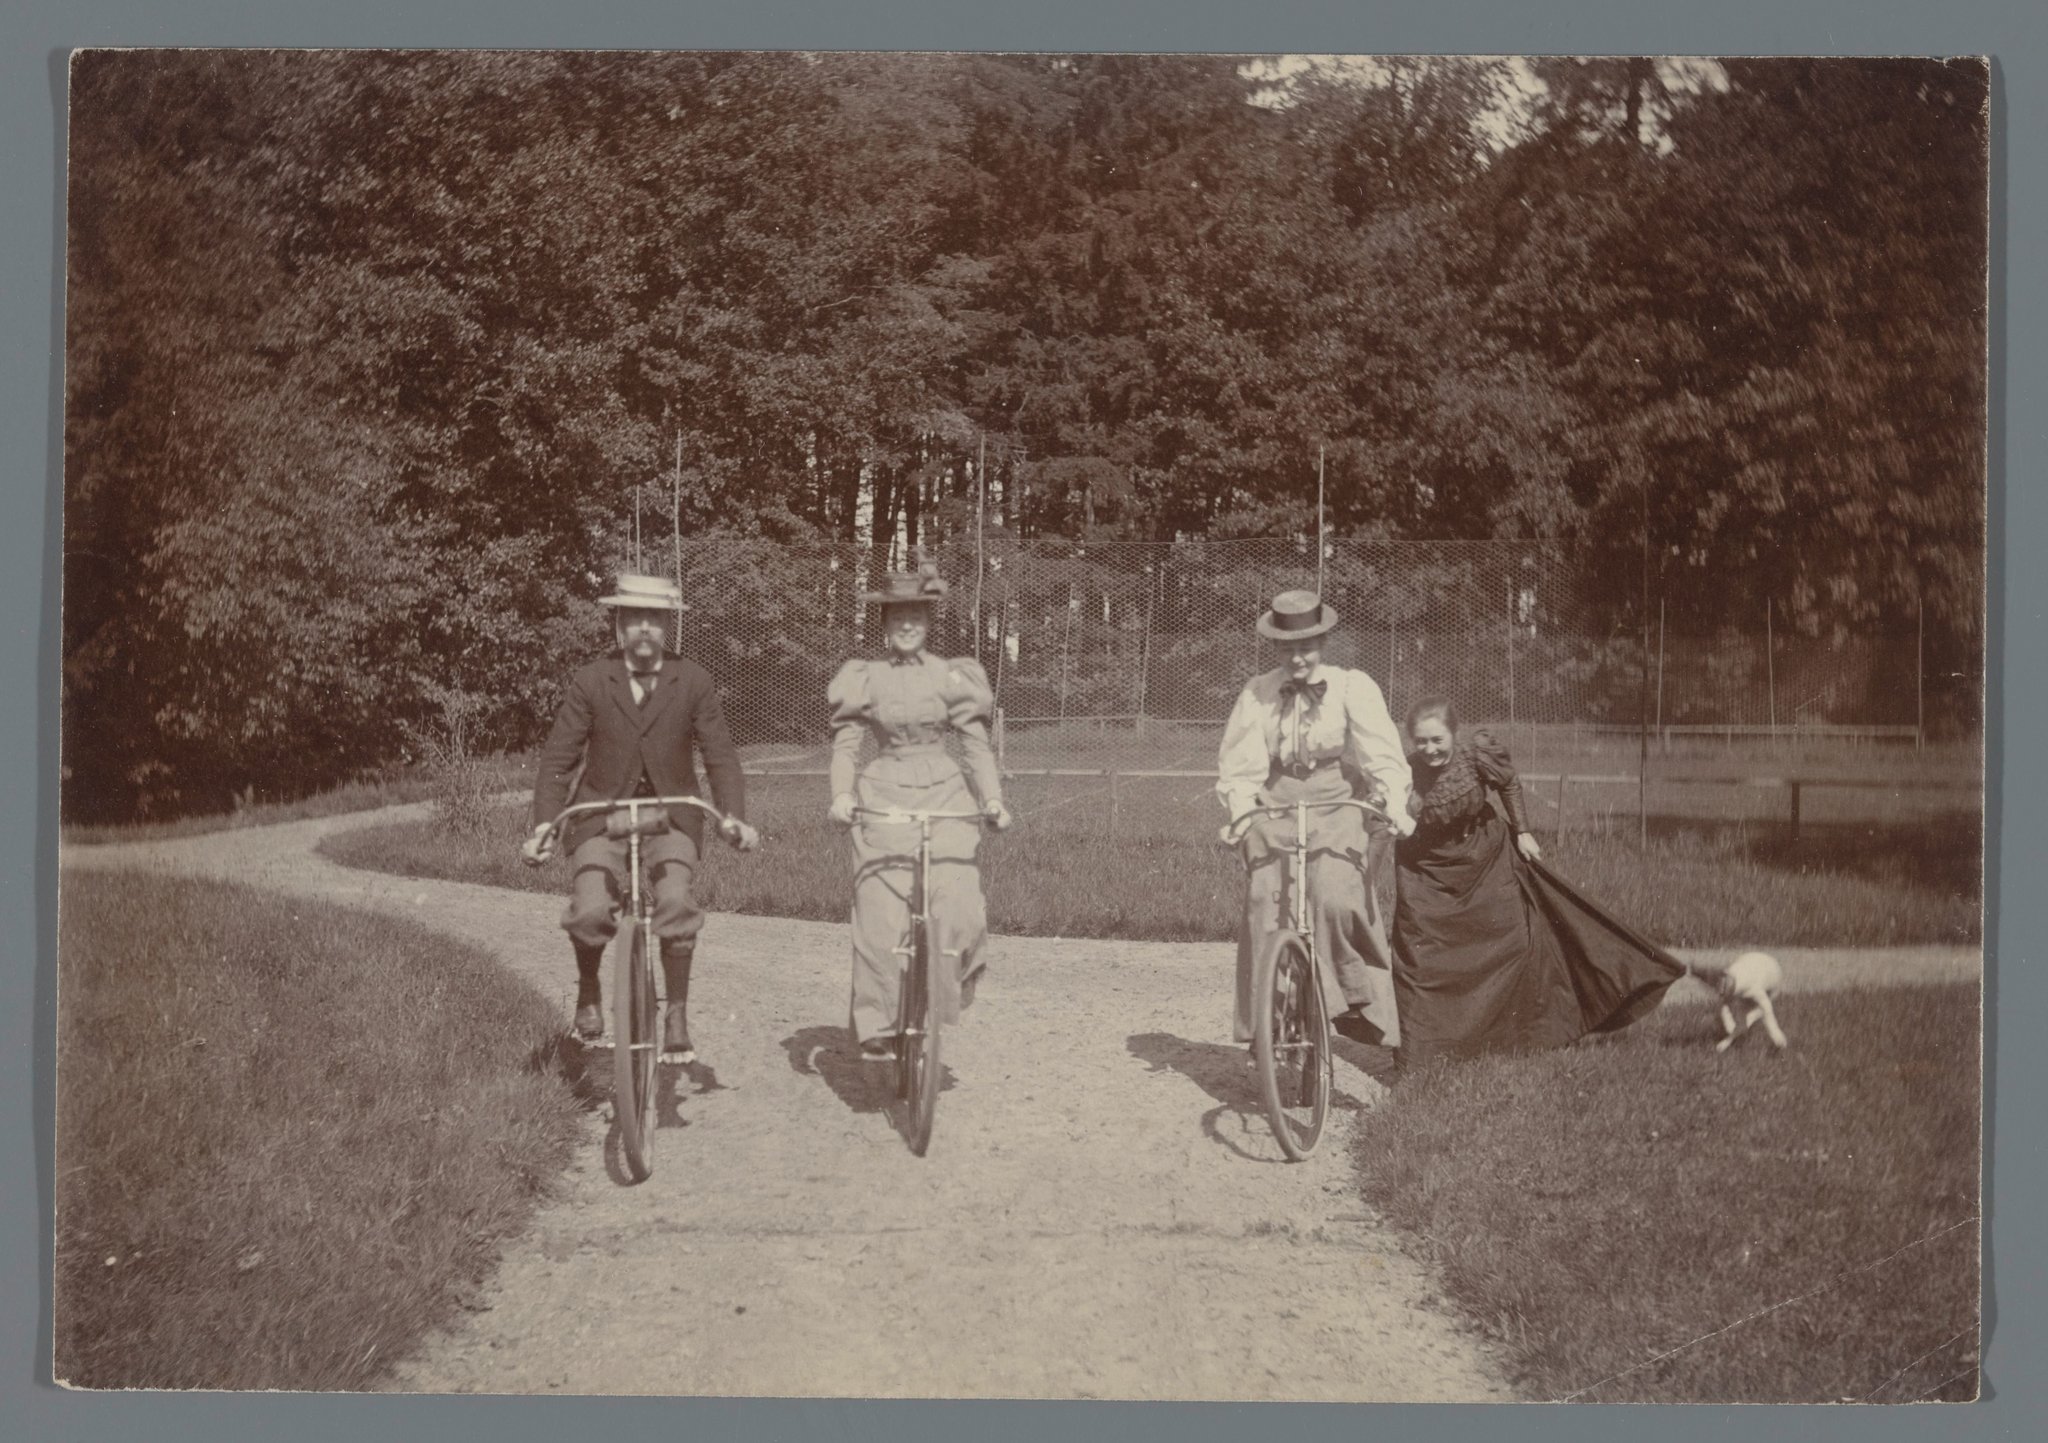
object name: photograph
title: Groepsportret op de fiets van Willem, Maria Engelina, Jennigje Hendrika Jacoba en Johanna Geertruida Jonker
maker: cornelia hendrika jonker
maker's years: 1874-1924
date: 1890-1910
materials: photographic support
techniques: collodion silver print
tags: historical persons, bicycle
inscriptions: annotation: ‘Wil, Marie, Jen, Jo Jonker’